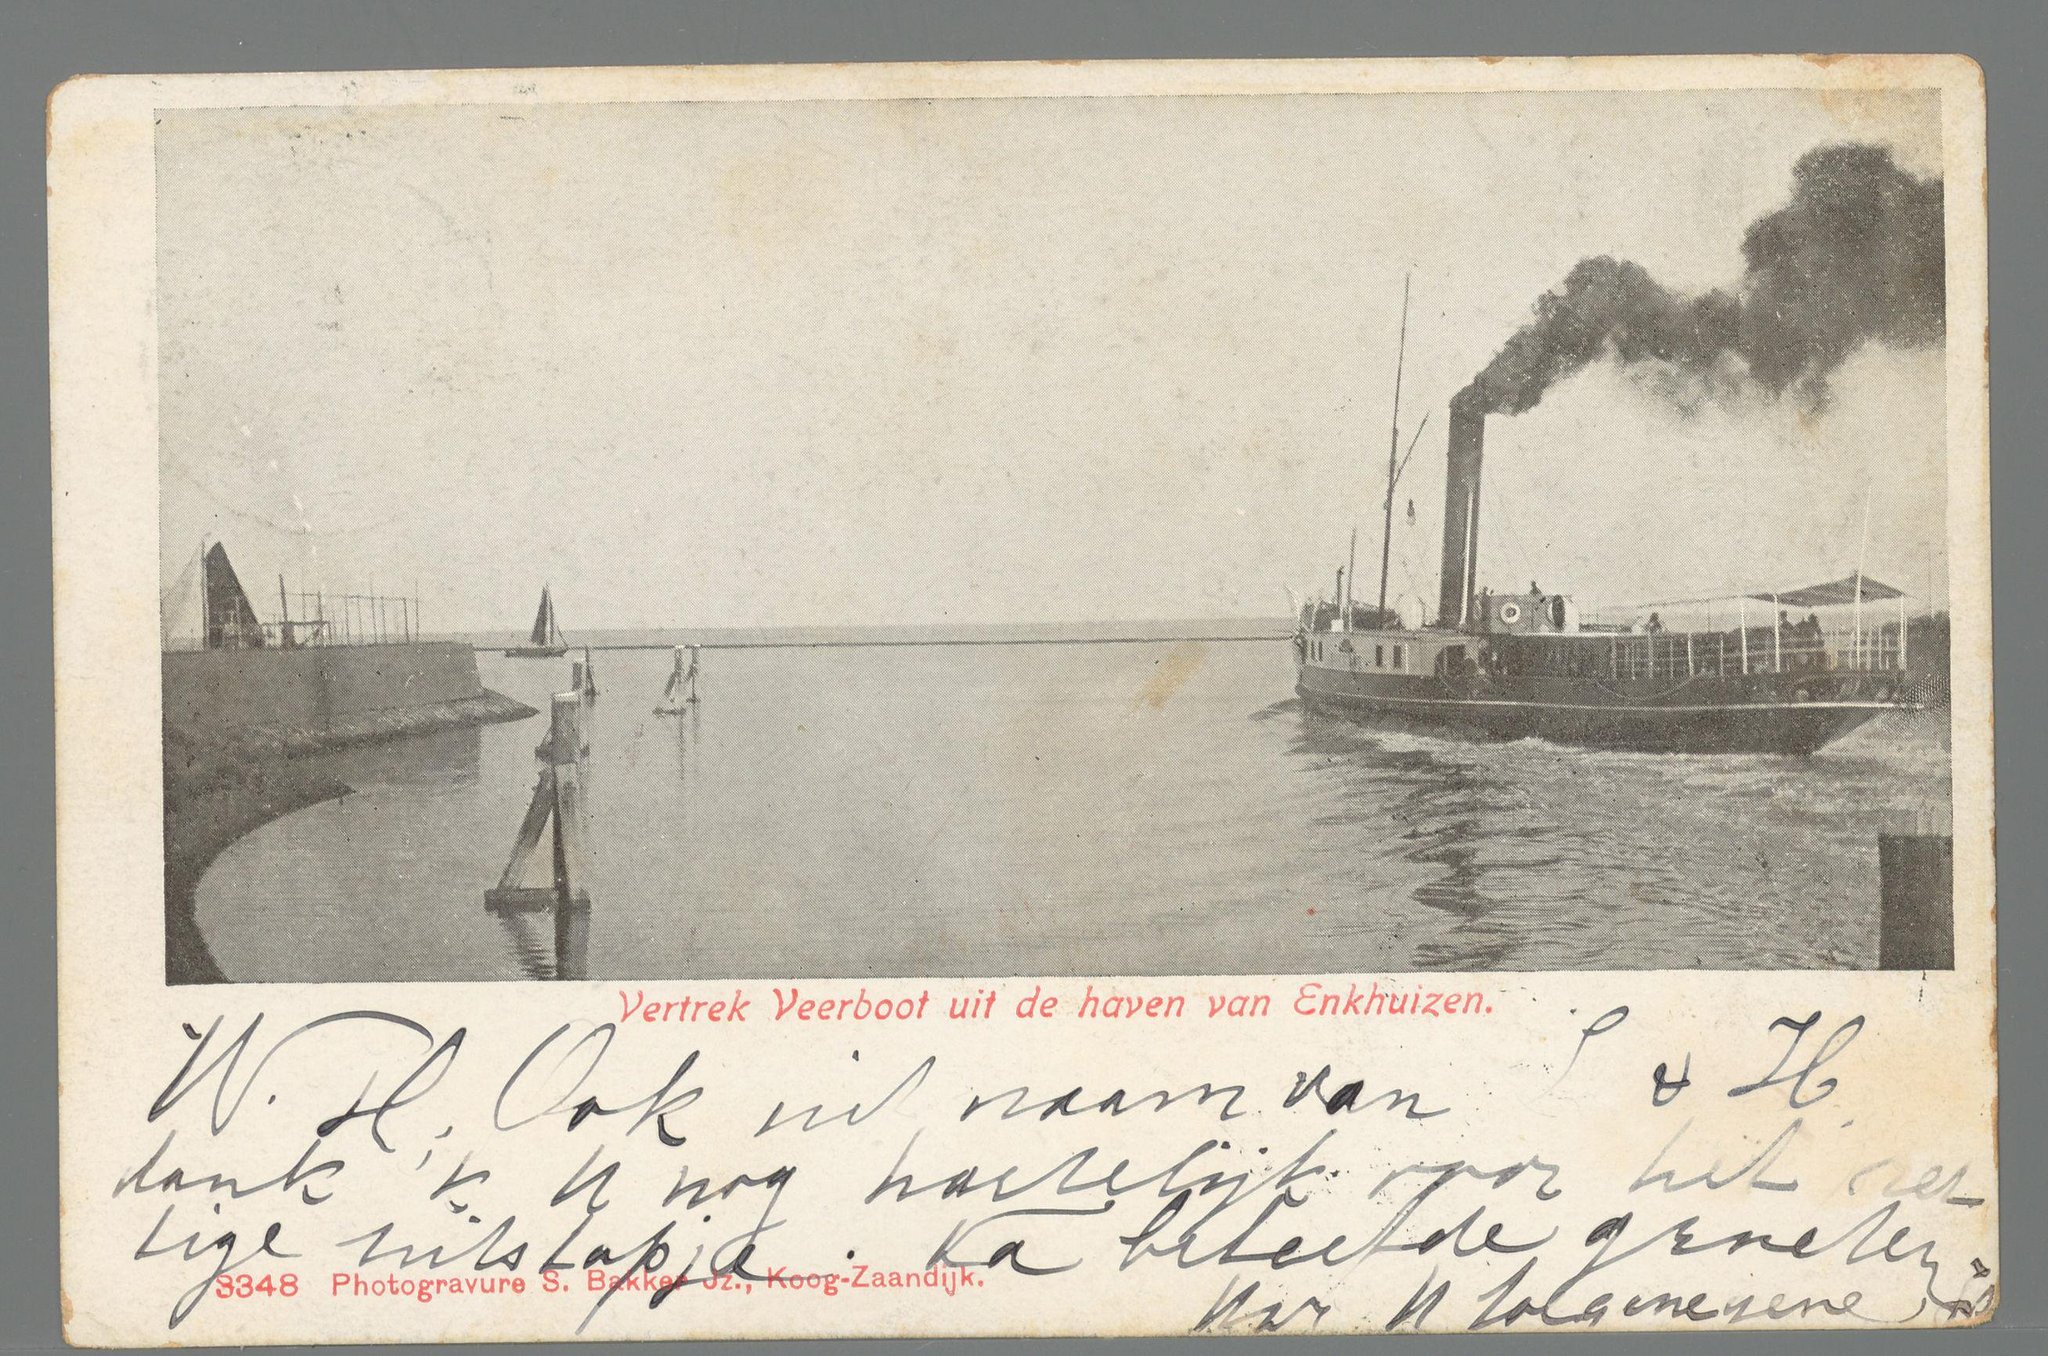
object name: photomechanical print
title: Vertrek veerboot uit de haven van Enkhuizen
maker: simon bakker jz.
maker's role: printer, publisher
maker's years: 1873-1930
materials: cardboard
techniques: writing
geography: koog aan de zaan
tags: harbour, ferry, steamship, motorship, enkhuizen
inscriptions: postage stamp